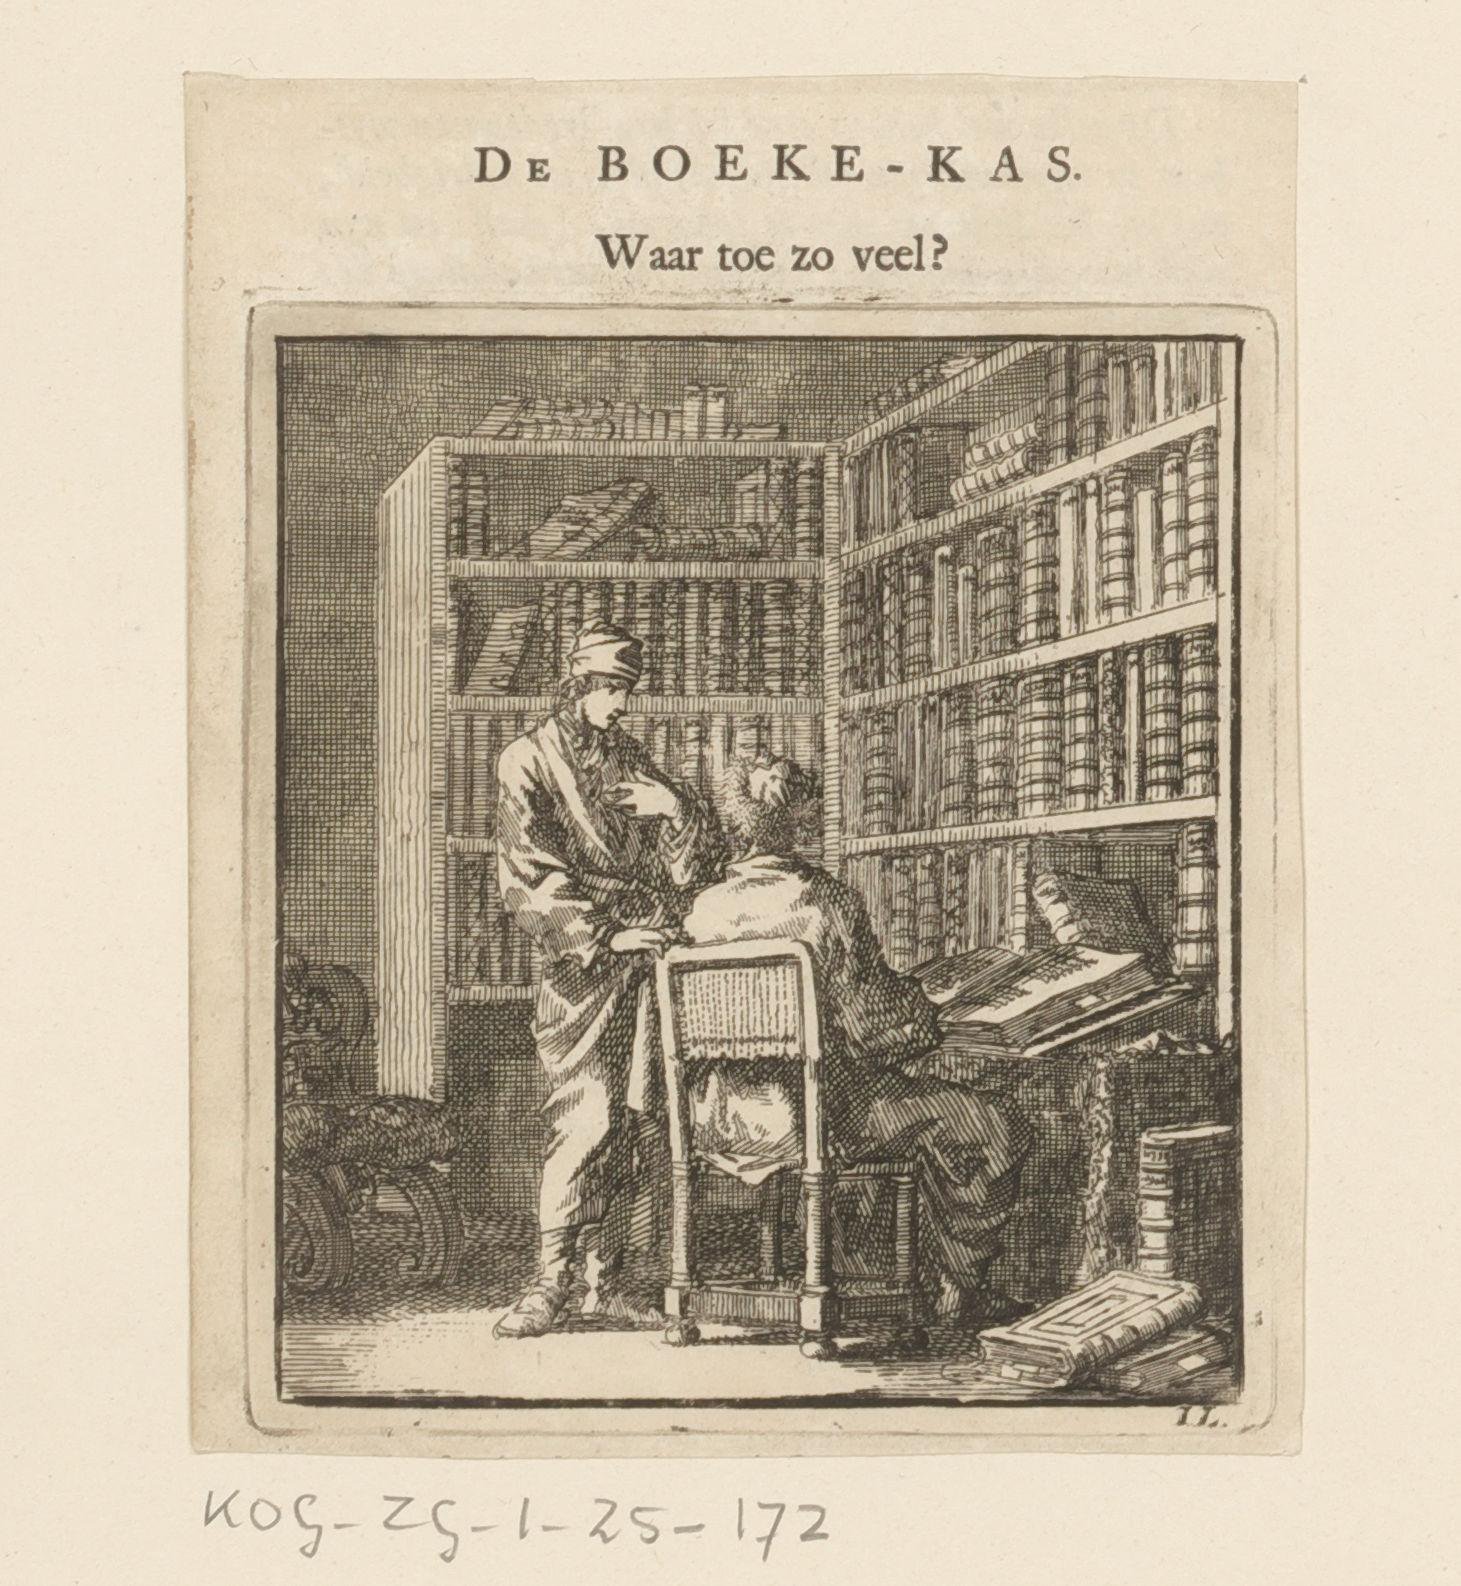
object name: print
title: De Boeke-kas. Waar toe zo veel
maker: jan luyken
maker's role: draughtsman, print maker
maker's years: 1649-1712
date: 1711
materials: paper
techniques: etching, letterpress printing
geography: amsterdam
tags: reading, book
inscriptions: collector's mark: Lugt 1641, stamp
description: Prent uit: Luyken, Jan. Het leerzaam huisraad, vertoond in vyftig konstige figuuren, met godlyke spreuken en stichtelyke verzen. Amsterdam: weduwe Pieter Arentsz. II en Cornelis van der Sys, 1711, p. 72.